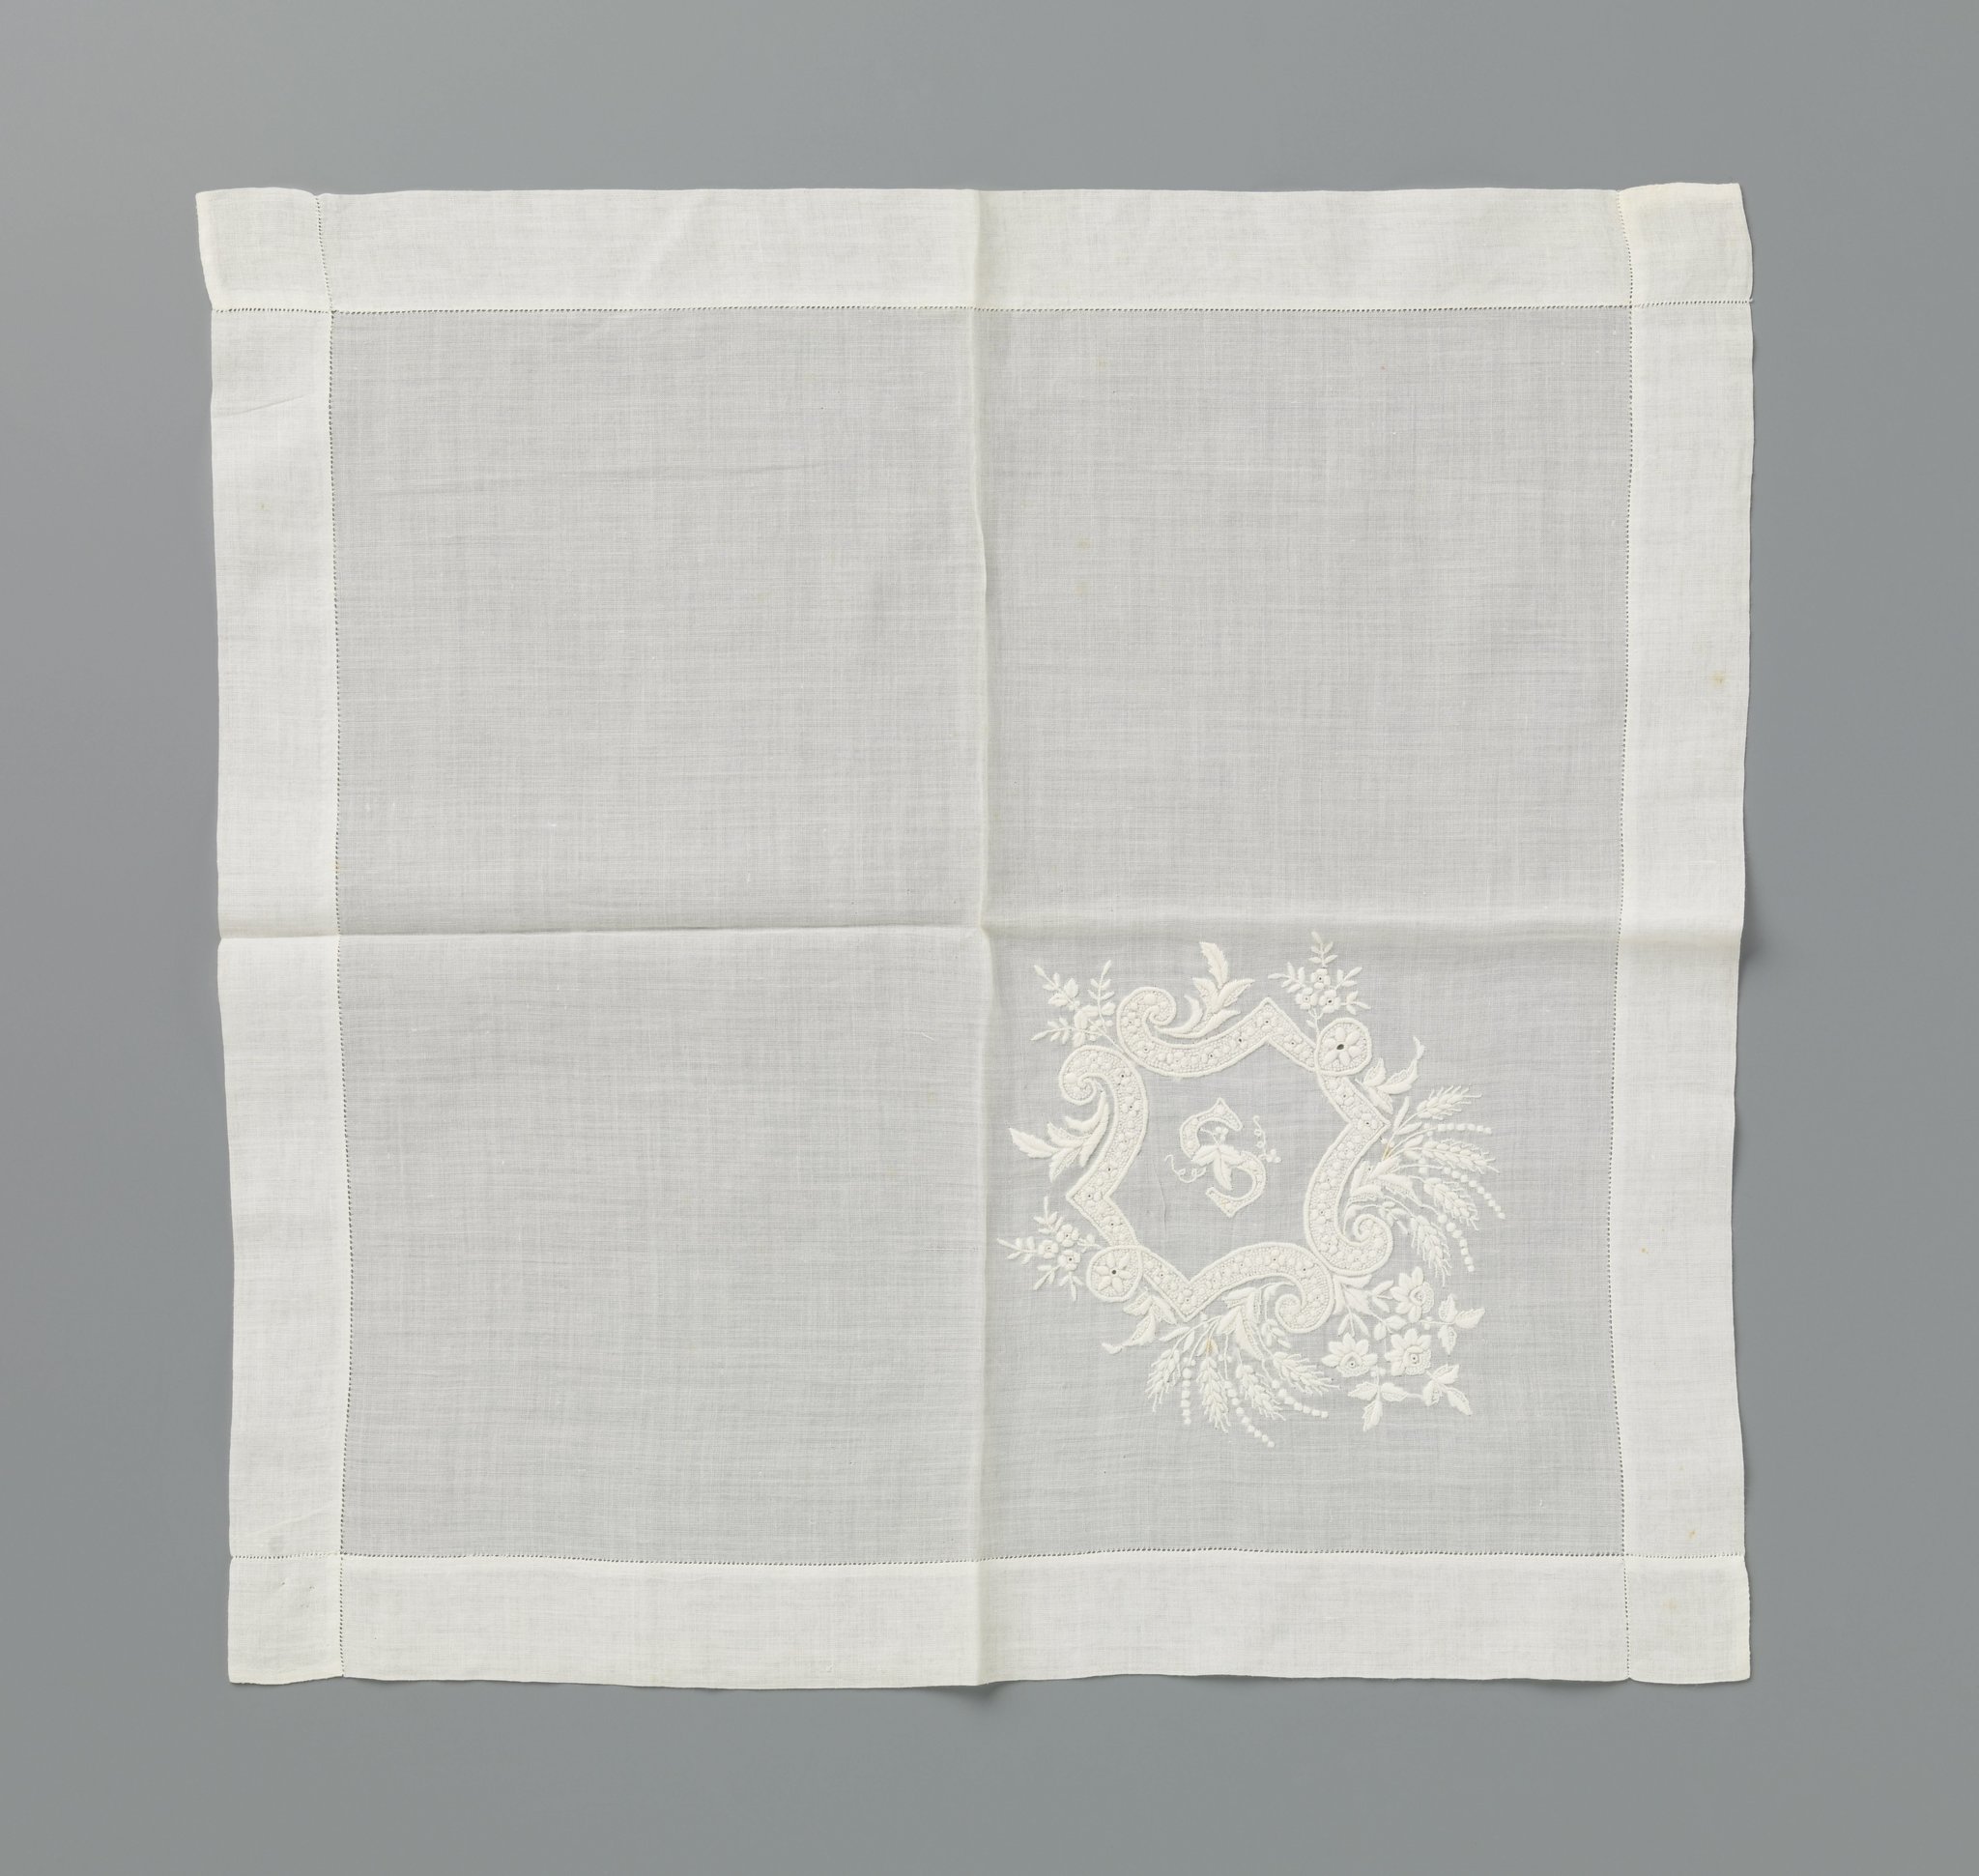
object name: womenswear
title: Batisten zakdoek met S-monogram in witwerk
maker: Anonymous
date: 1840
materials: textile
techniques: embroidery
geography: netherlands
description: Zakdoek van batist met witwerk. In één van de hoeken is een S-monogram geborduurd binnen een groot symmetrisch cartouche. Het cartouche bestaat uit een recht en rondlijnig bandwerk gevuld met vergeet-mij-nieten. Buiten het cartouche zijn bloemen en twee bossen korenaren geborduurd.